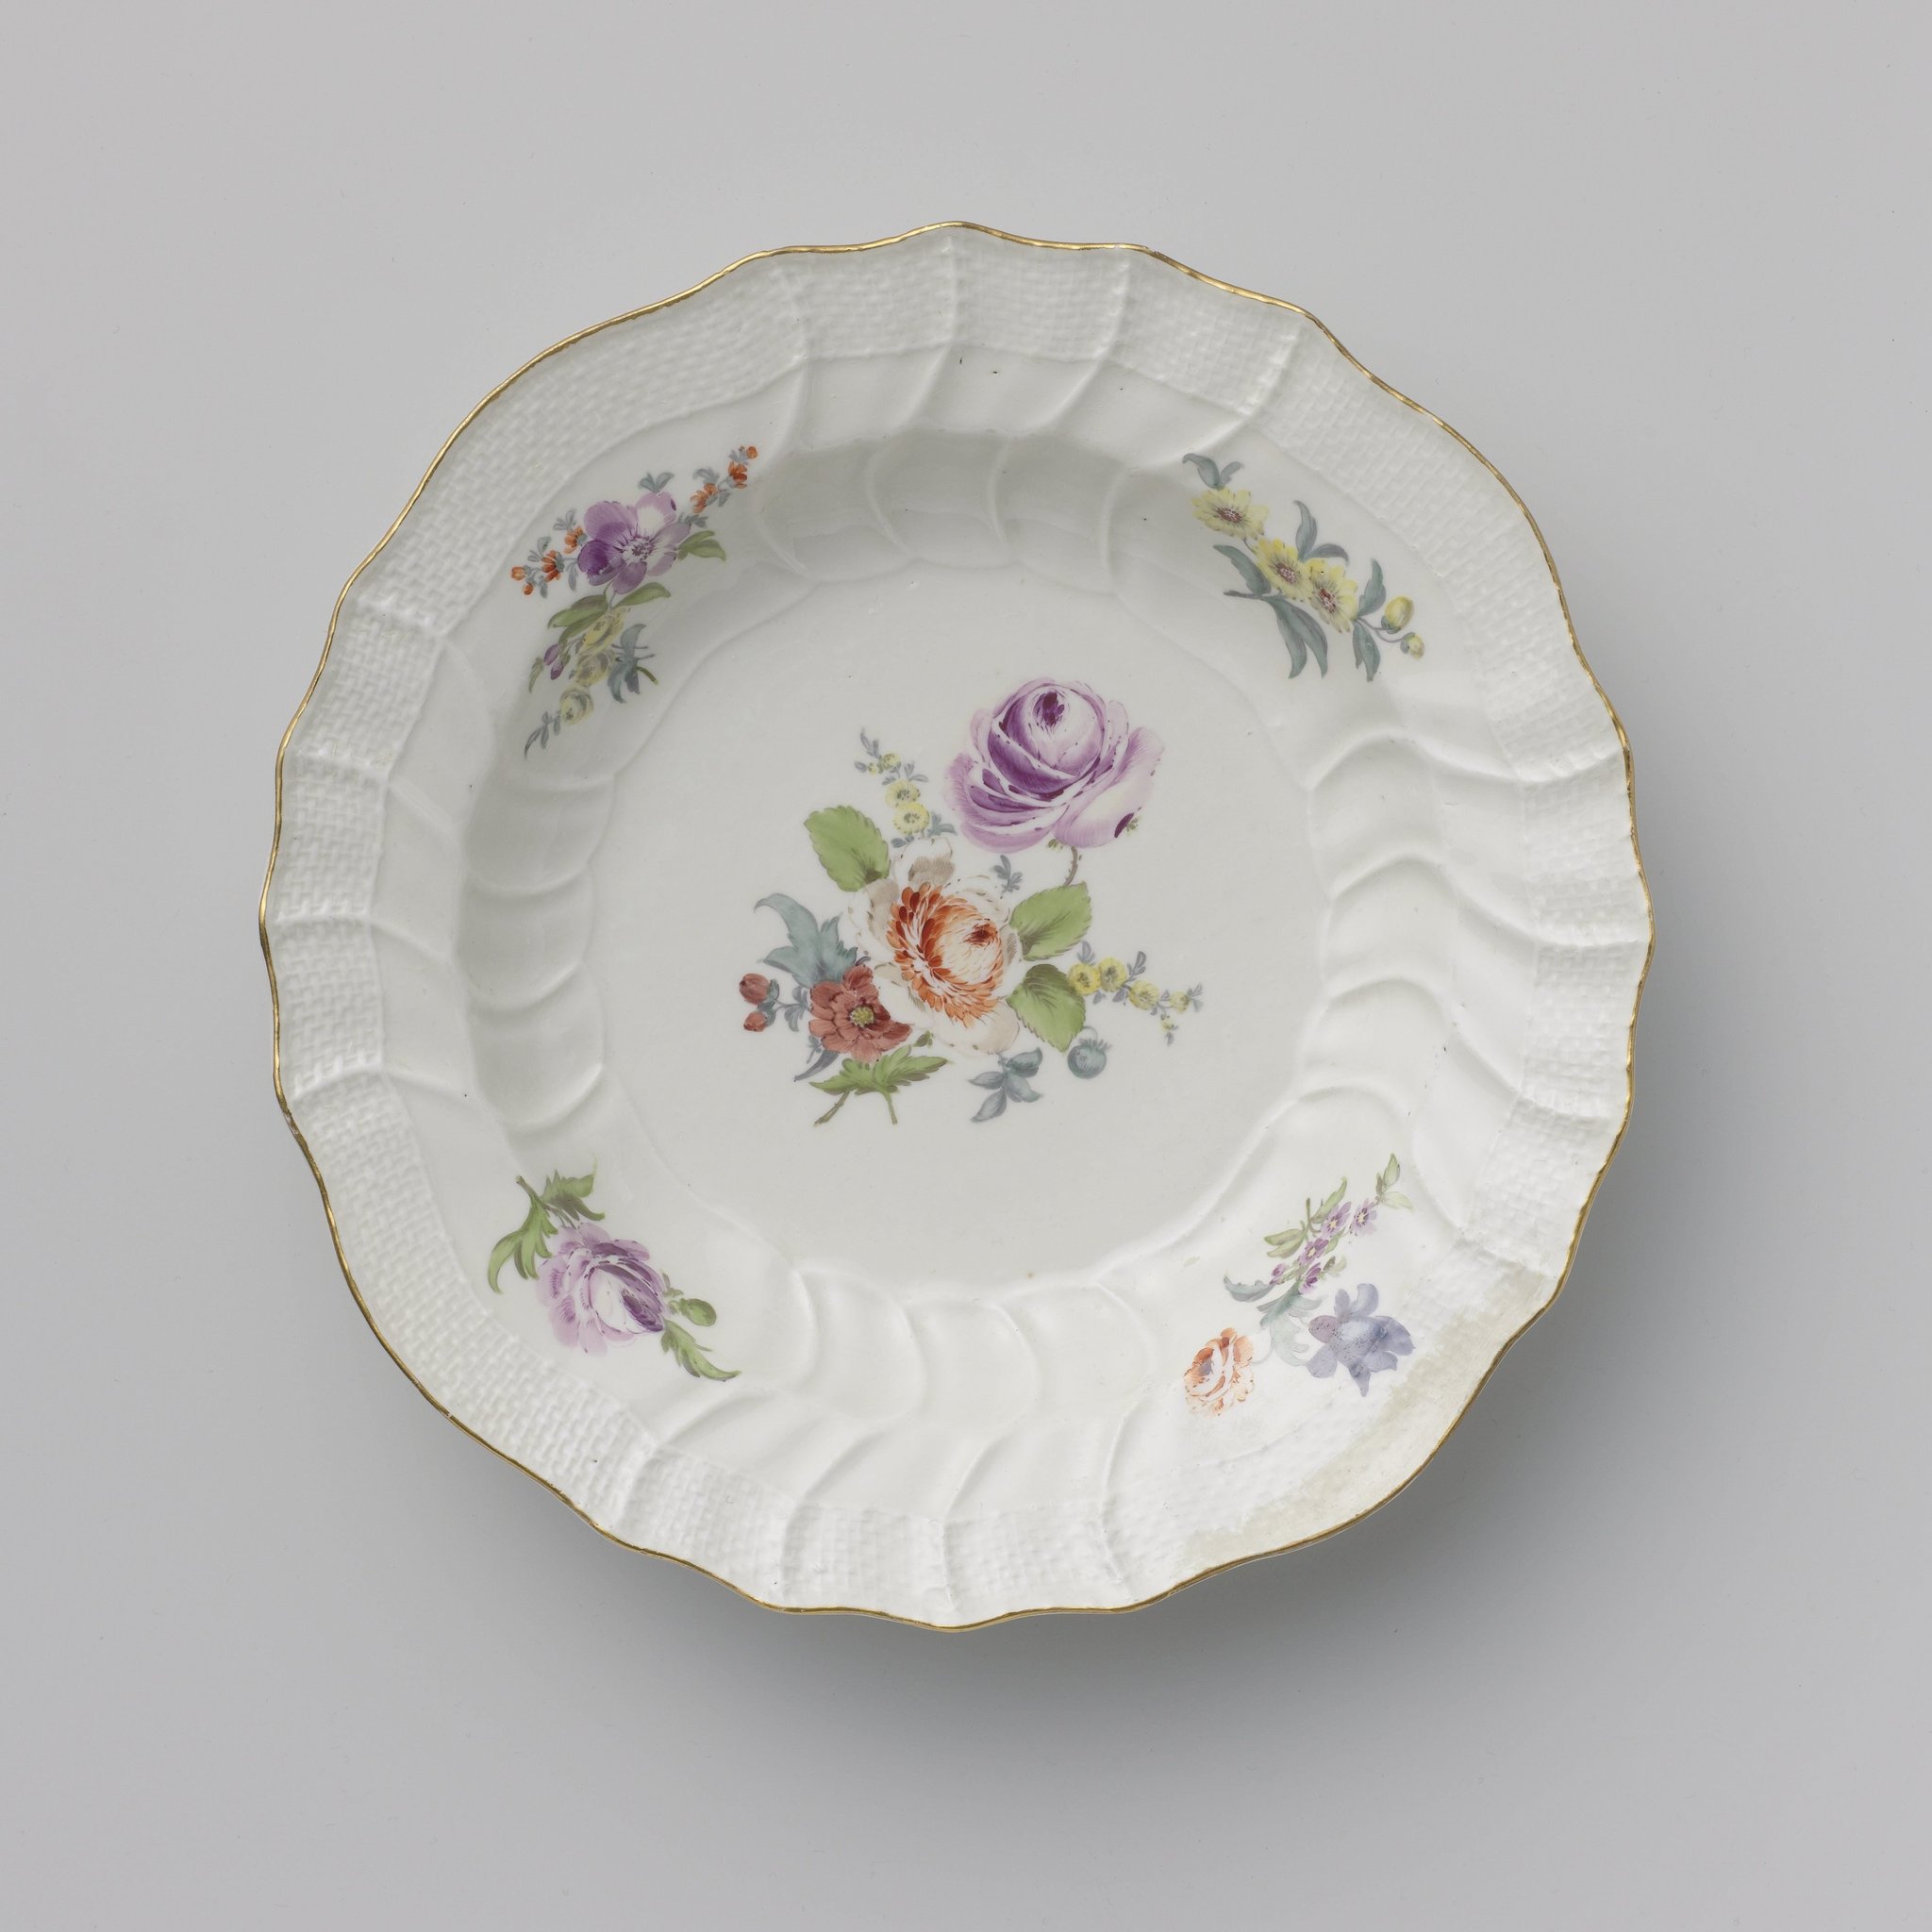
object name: plate dish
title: Bord, veelkleurig beschilderd met Deutsche Blumen, insekten en vruchten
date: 1750-1760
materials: porcelain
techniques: painted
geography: meissen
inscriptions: factory mark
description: Rond soepbord van beschilderd porselein. Het bord is beschilderd met Deutsche Blumen, insekten en vruchten. De rand is in reliëf versierd met het Neuozier-patroon. Het bord is gemerkt en hoort bij een servies (BK-17474-1 t/m BK-17474-253).